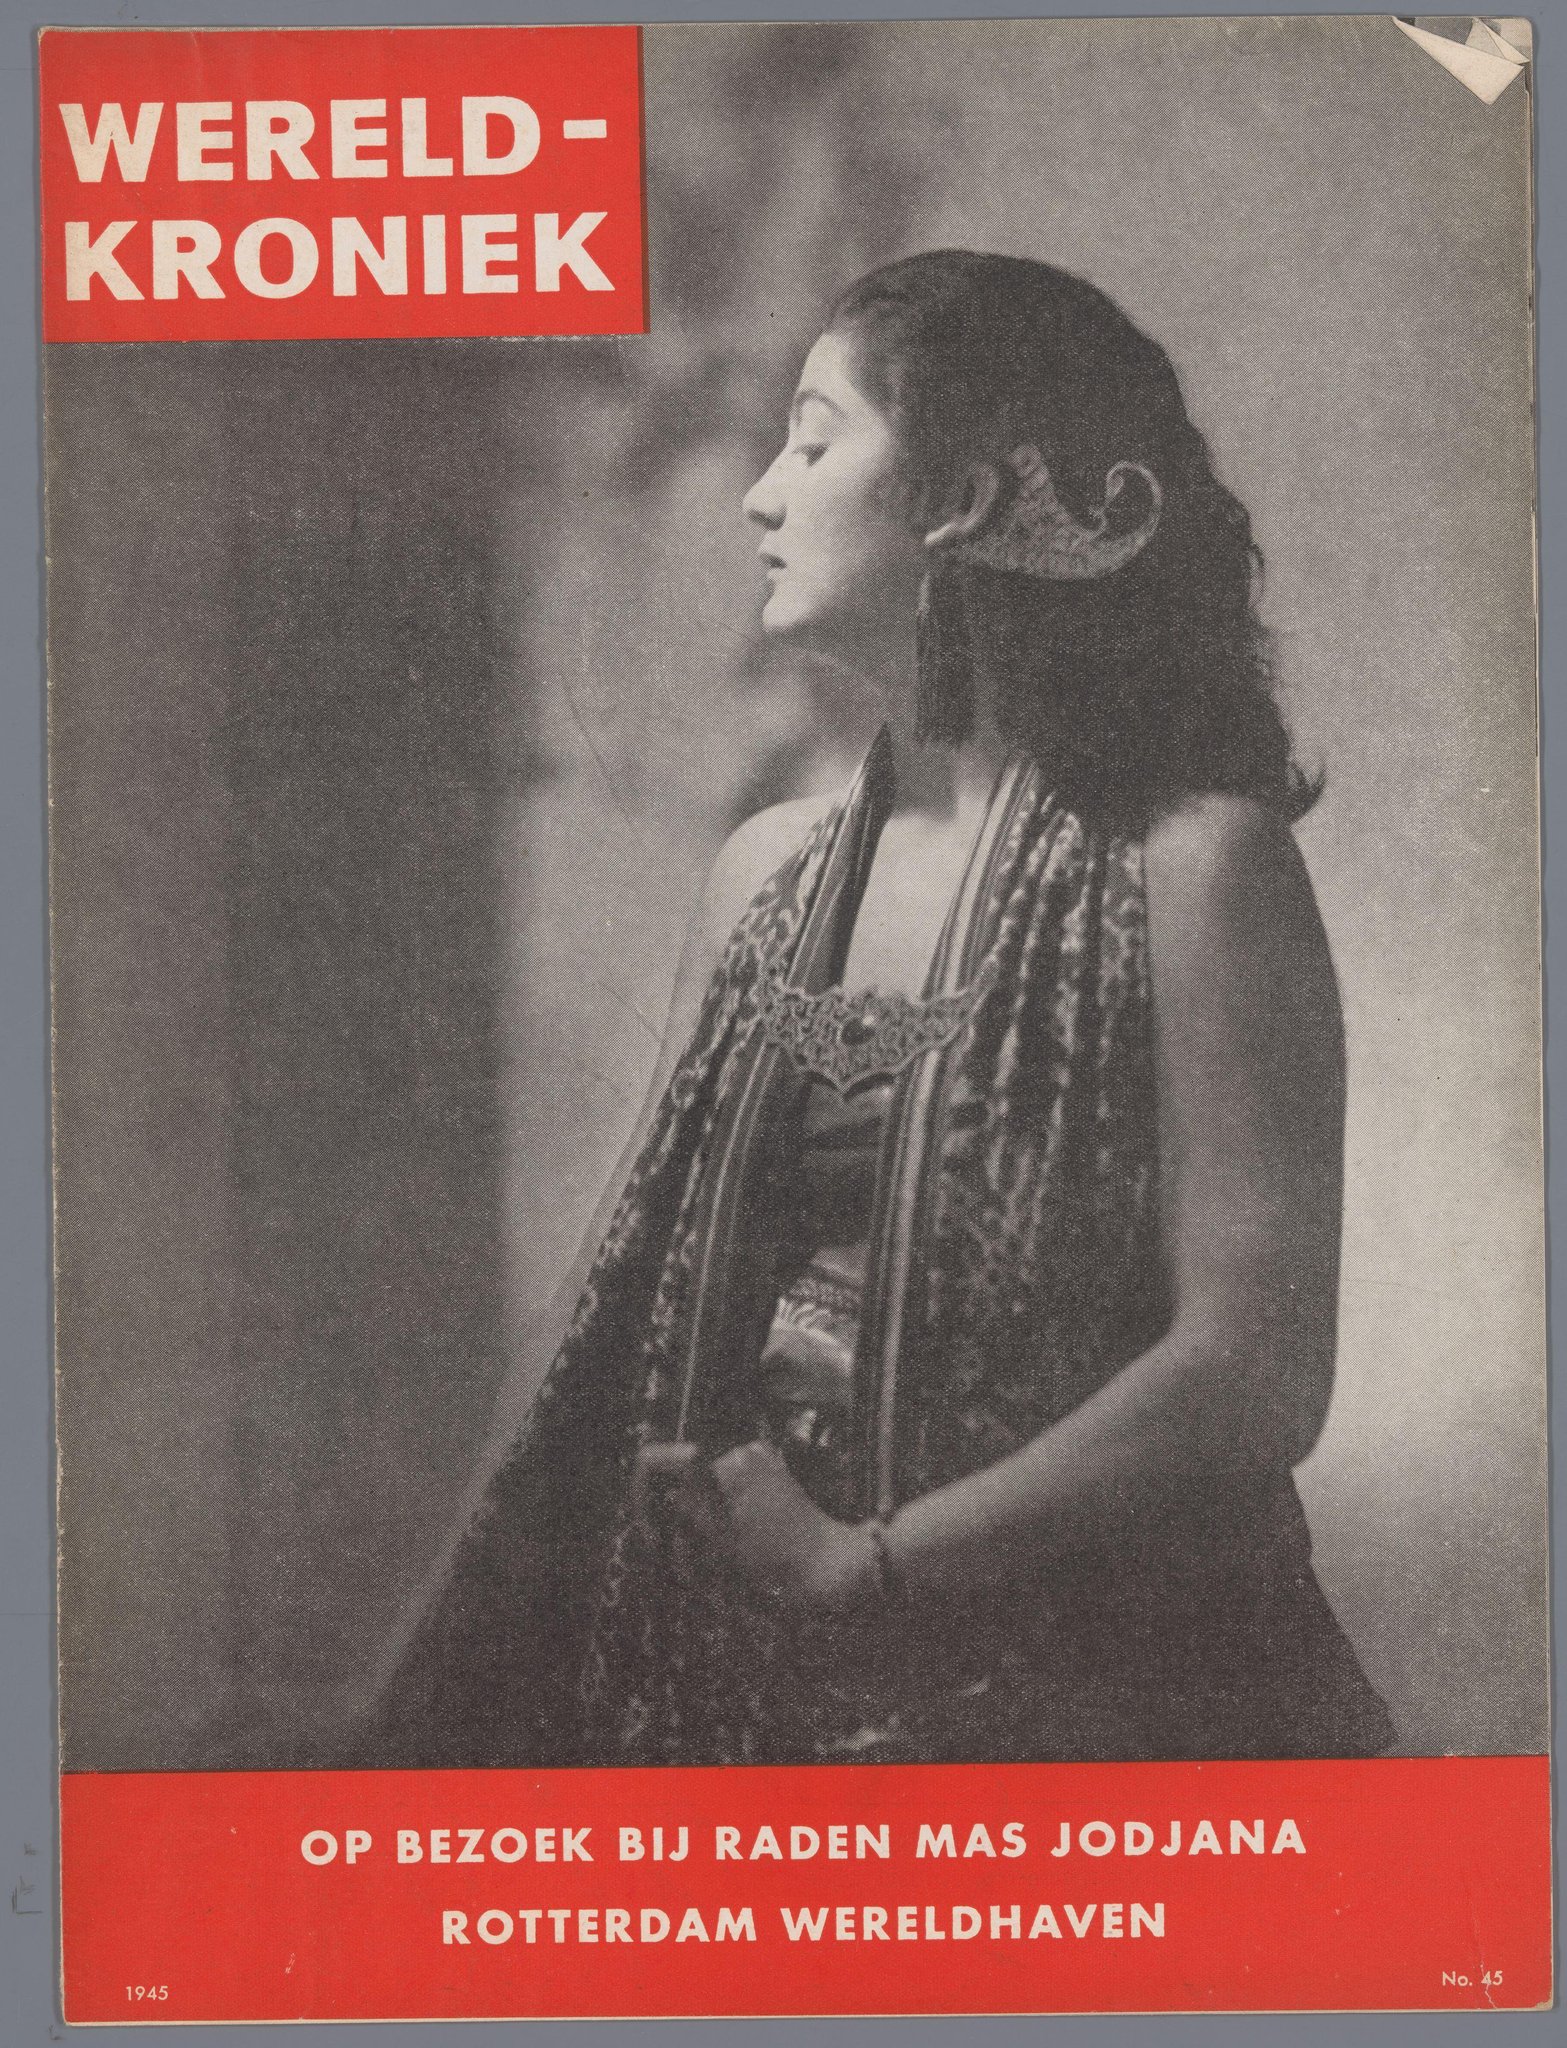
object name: magazine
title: Wereld-kroniek, 10 november 1945 (48e jaargang)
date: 1945-1946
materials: paper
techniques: printing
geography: the hague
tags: tweede wereldoorlog, bevrijding van nederland (1945)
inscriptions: inscription: ‘WERELD-KRONIEK’, date: ‘10 november 1945’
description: Tijdschrift met op omslag een zwart-wit foto. R.b. een rood fond waarop in witte letters het opschrift, onderaan eveneens een rode baan met daarop titel van hoofdonderwerp per aflevering. Ongeveer 14 pagina's. Nummer behoort tot 48e jaargang. Inhoud: algemeen nieuws van hele wereld, met foto's en advertenties.